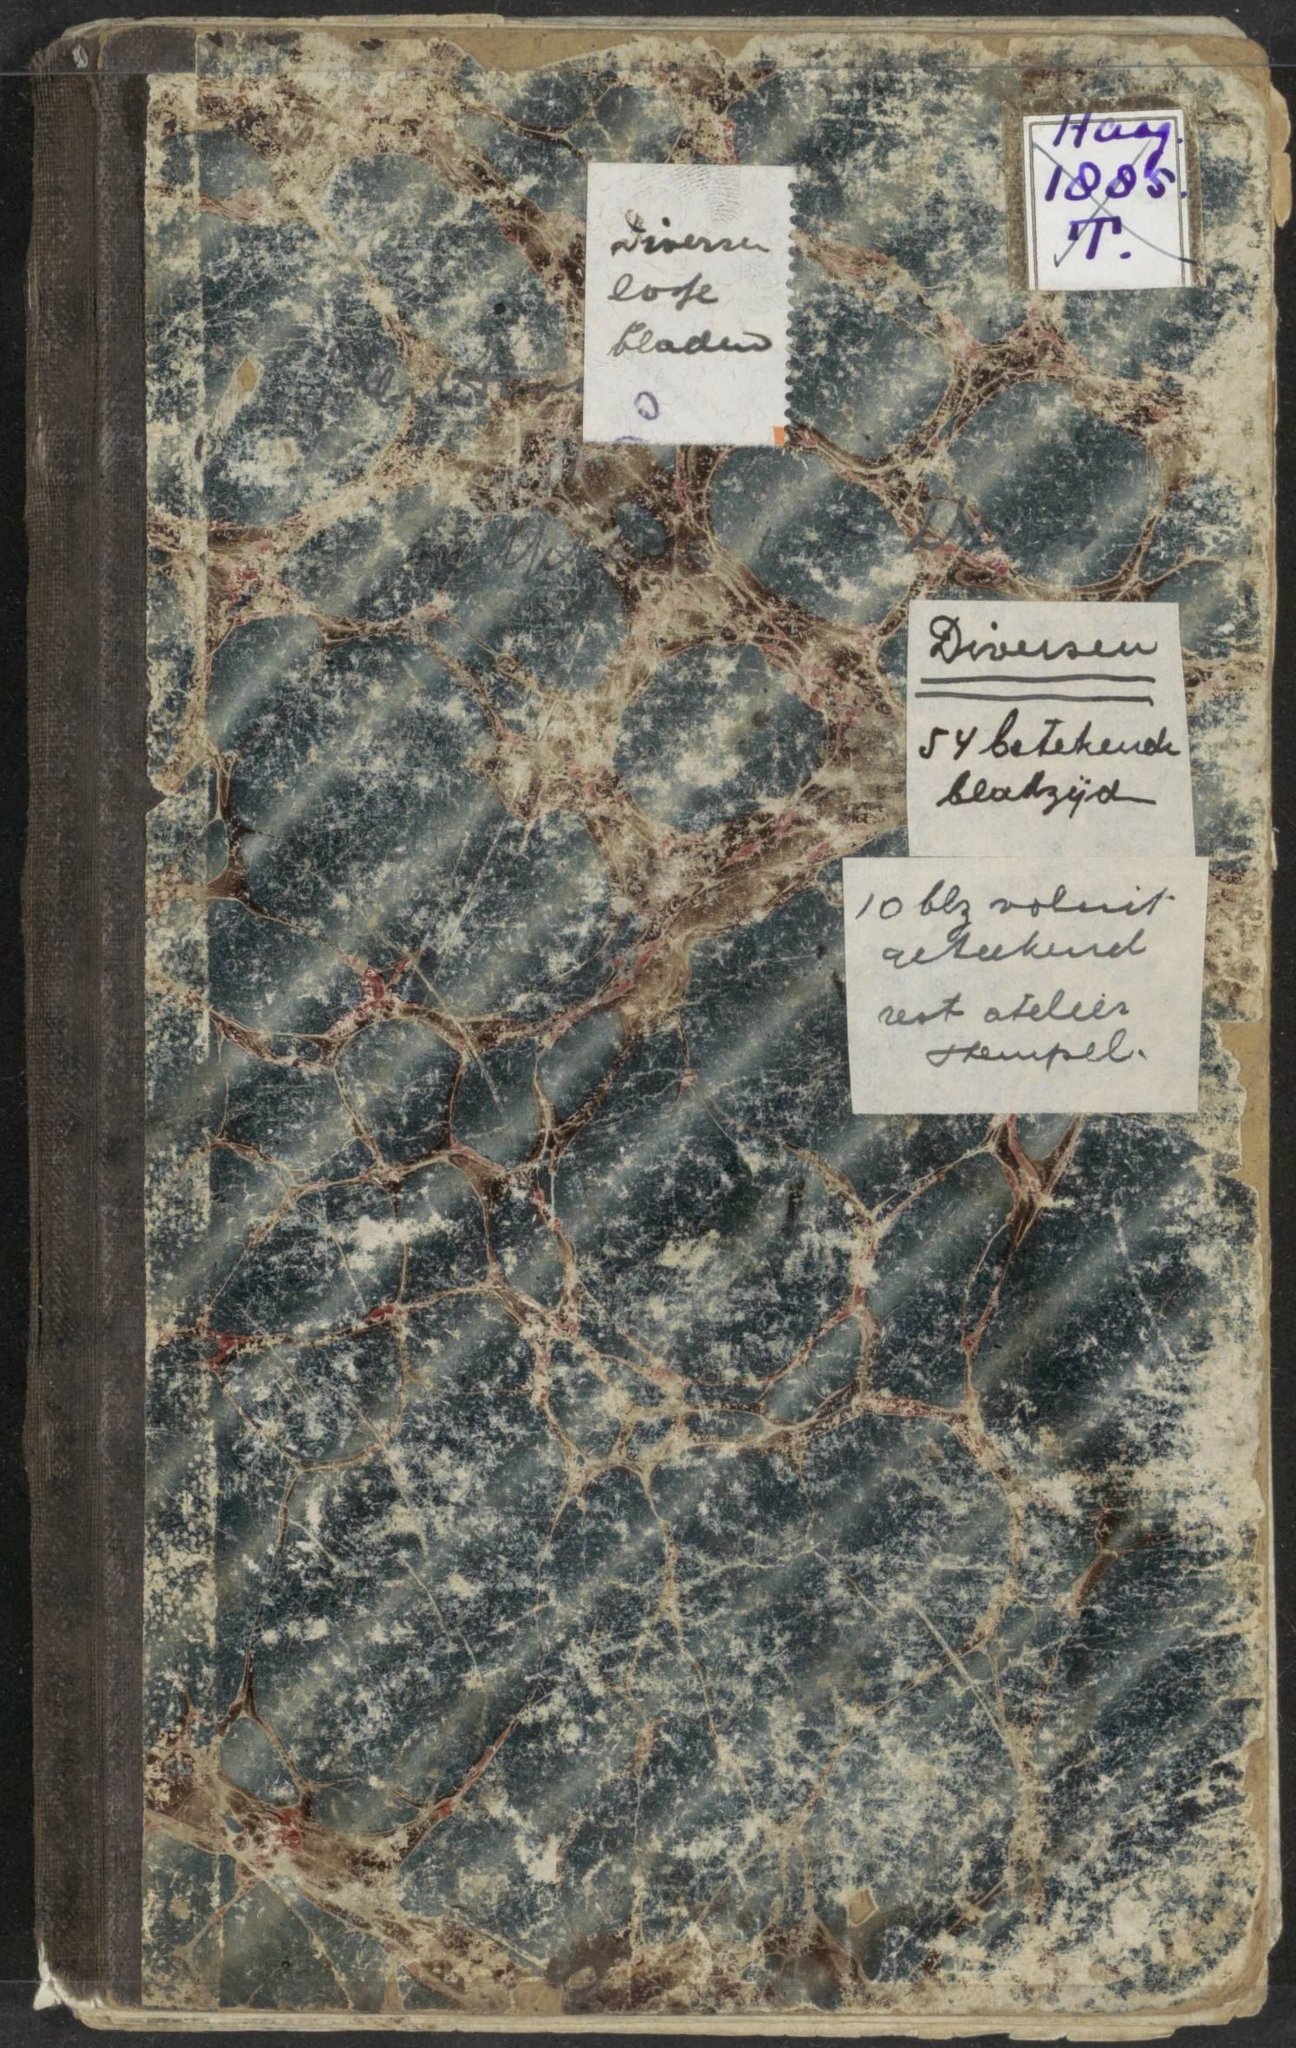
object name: sketchbook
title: Schetsboek met 9 bladen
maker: george hendrik breitner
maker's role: draughtsman, painter, print maker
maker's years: 1857-1923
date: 1881-1883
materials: cardboard, chalk, linen, paper, pencil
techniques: marbling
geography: the hague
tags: saddle and bridle (saddlery)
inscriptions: collector's mark: Lugt 2228, annotation: ‘Haag./ 1885./ T./ Diversen/ losse/ bladen/ Diversen/ 54 betekende bladzijden/ 10 blz voluit geteekend/ rest atelier/ stempel.’, workshop stamp: Lugt 291d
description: Schetsboek bestaande uit 9 bladen met paardentuig en militaire uitrustingen.